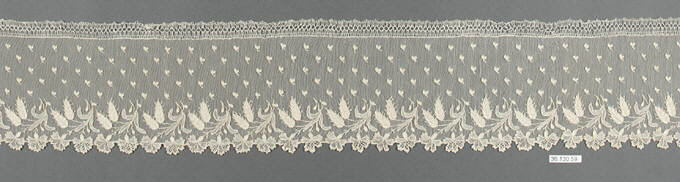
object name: border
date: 1801-1833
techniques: lace